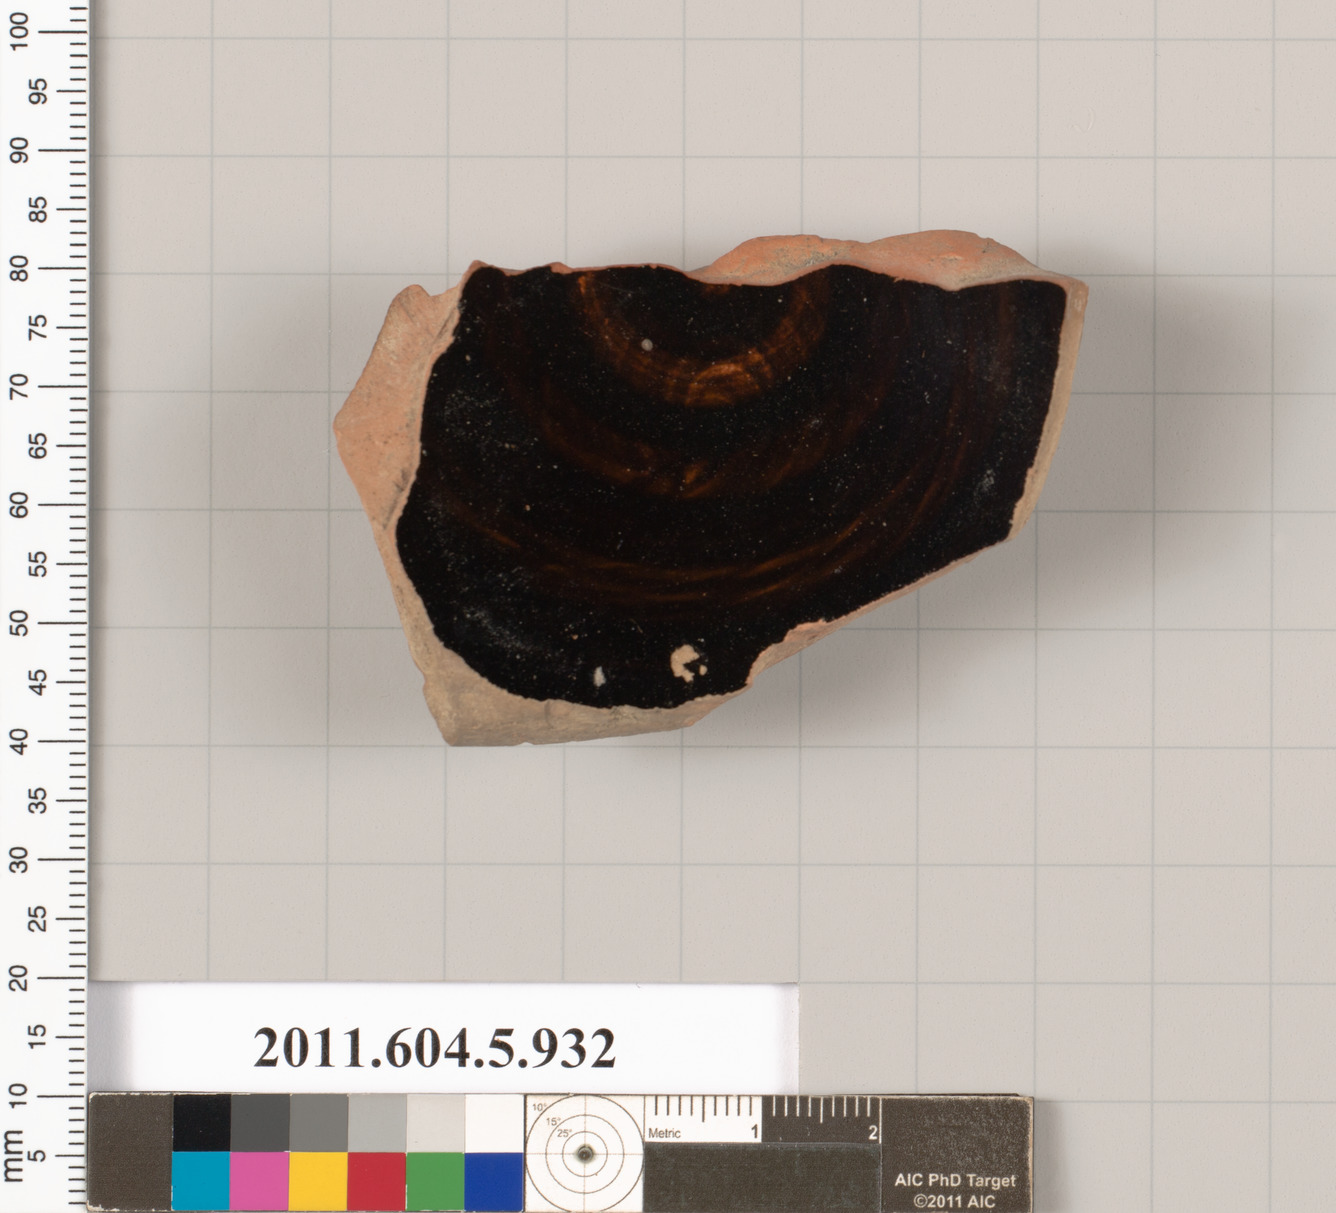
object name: kylix fragment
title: Terracotta fragment of a kylix (drinking cup)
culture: greek, attic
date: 600-401 BCE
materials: terracotta